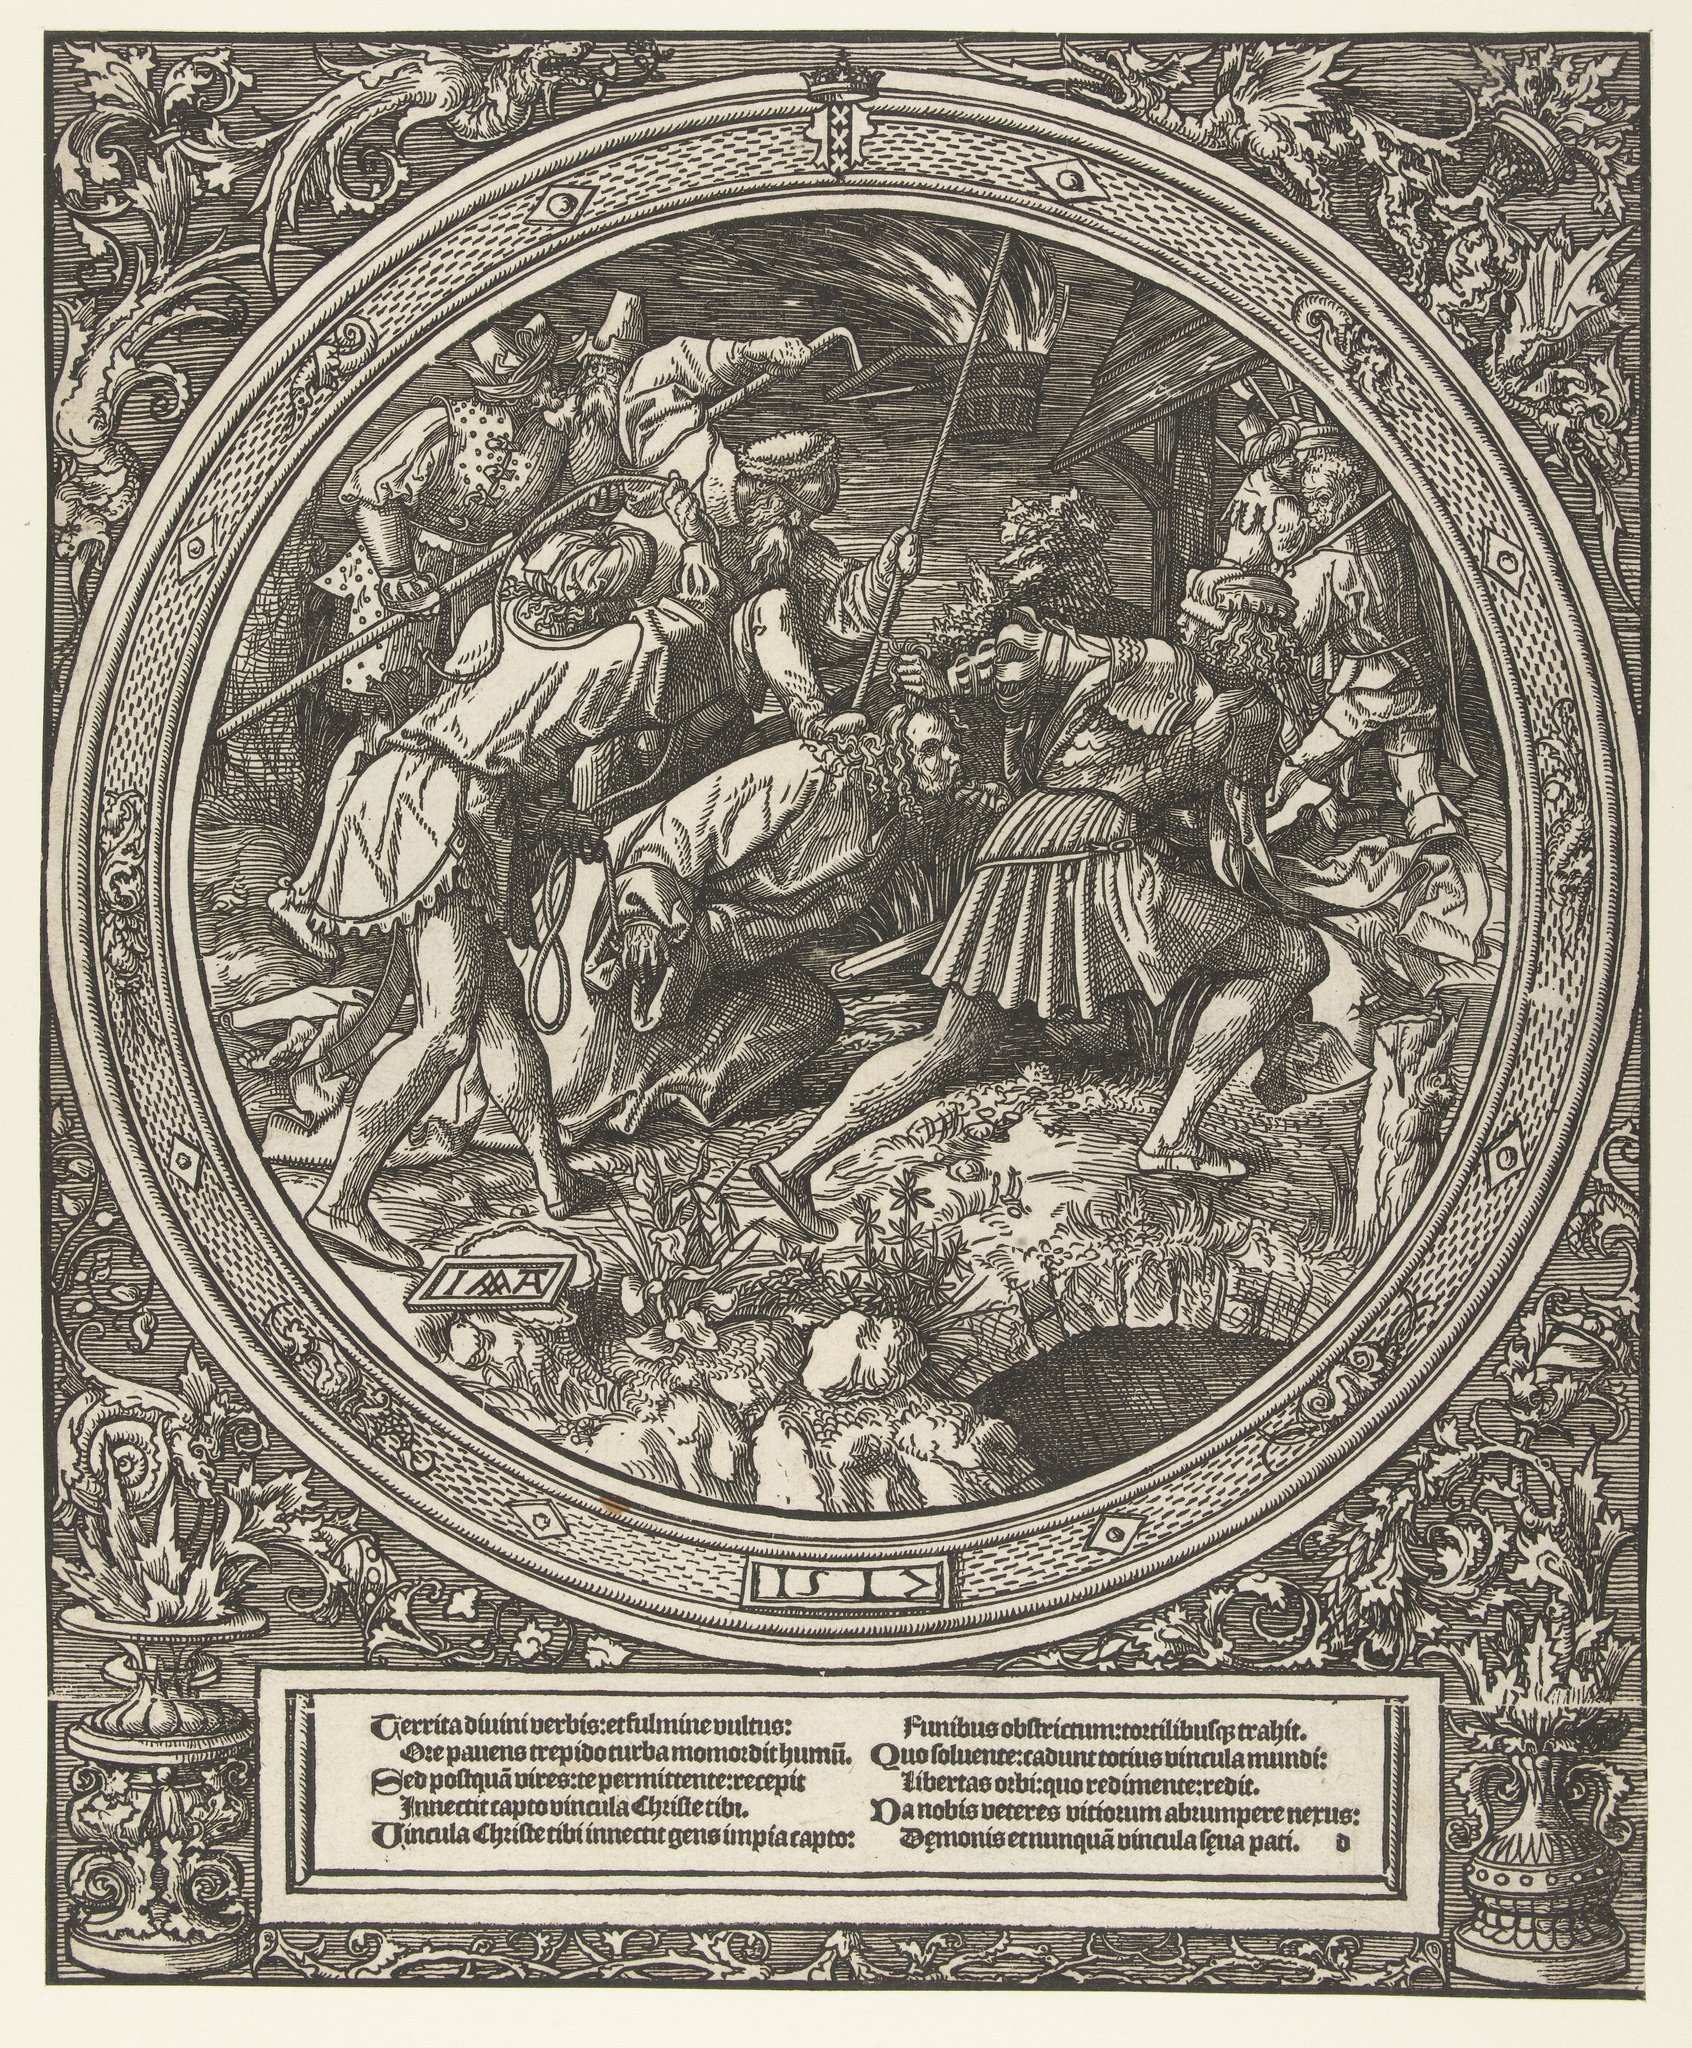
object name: print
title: De gevangenneming van Christus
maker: jacob cornelisz van oostsanen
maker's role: draughtsman, painter, print maker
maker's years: 1475-1533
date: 1517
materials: paper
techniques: woodcut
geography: low countries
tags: christ is led away ~ garden of gethsemane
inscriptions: collector's mark: Lugt 2165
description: Uit serie van twaalf prenten. Christus, geboeid, wordt door mannen geslagen en geduwd. Rond voorstelling ornamentele omlijsting. Onderaan kader met tekst in het Latijn. Gedrukt van meerdere blokken.